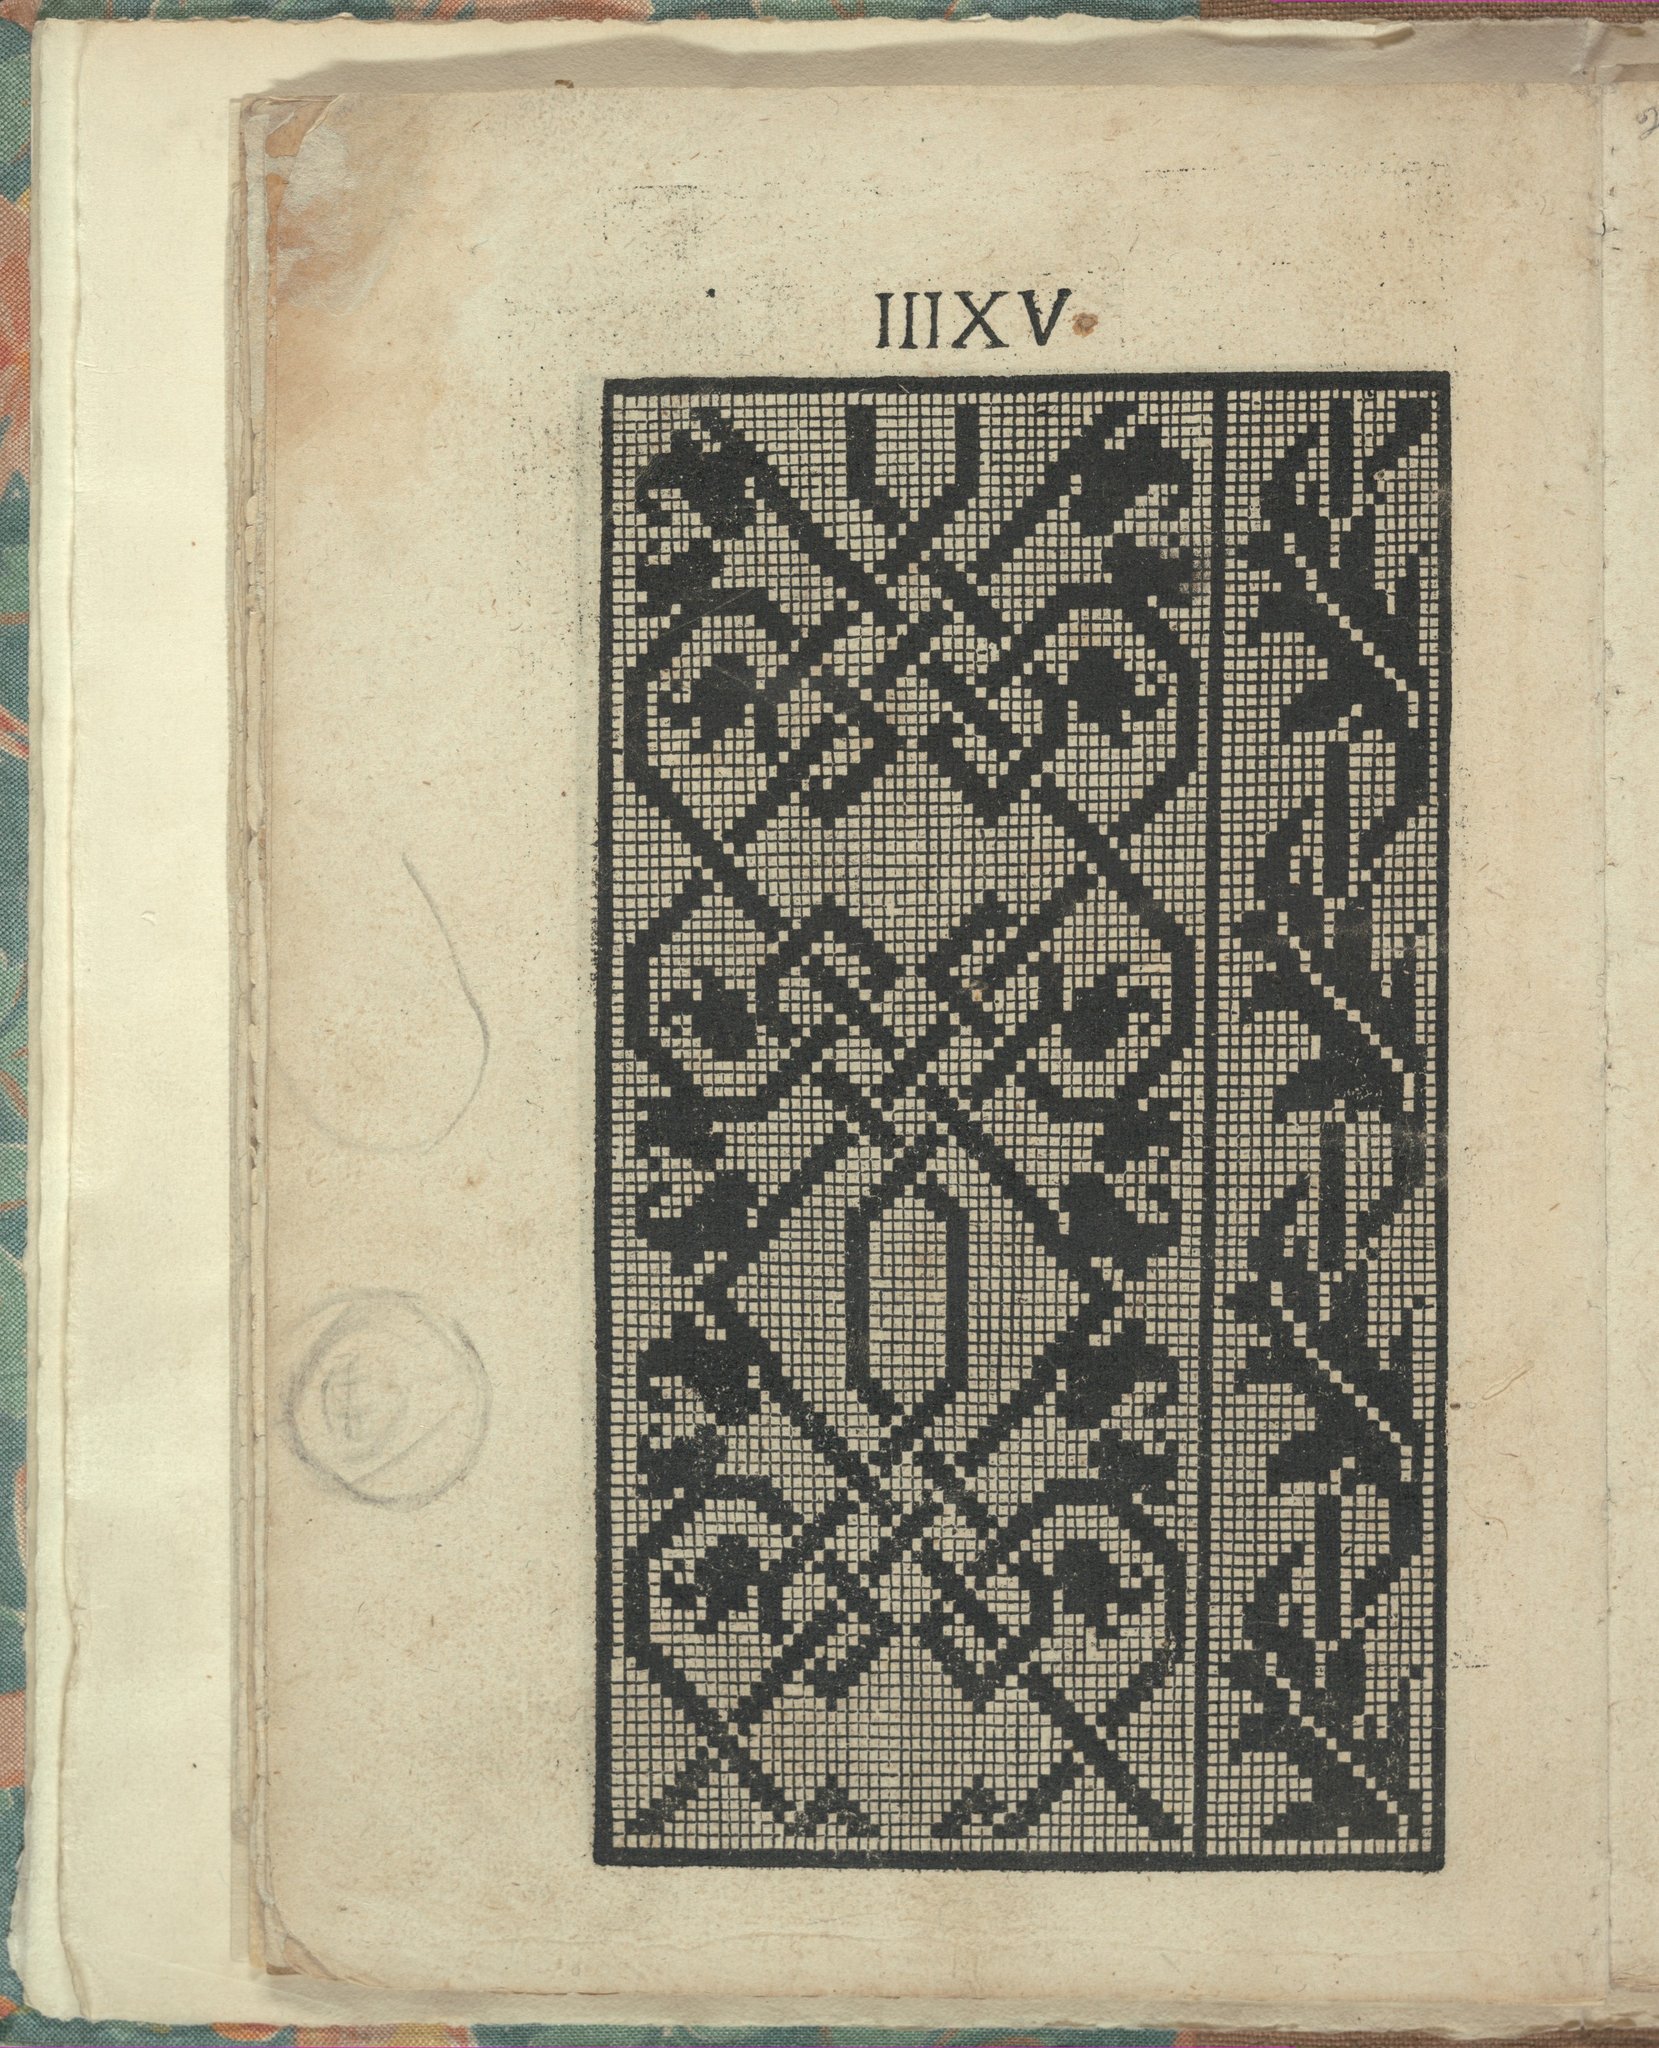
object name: book print ornament architecture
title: Opera Nova Universali intitulata Corona di racammi, page 20 (verso)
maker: giovanni andrea vavassore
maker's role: publisher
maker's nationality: italian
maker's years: 1530-1573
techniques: woodcut